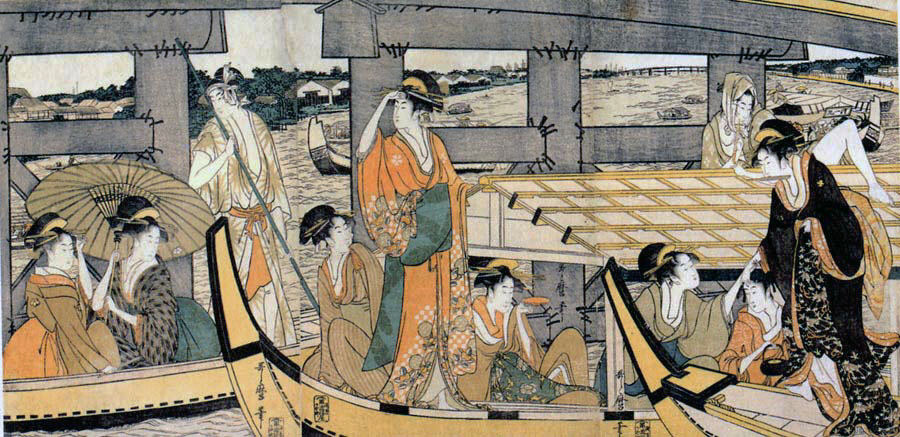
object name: print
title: Enjoying the Cool Evening Breeze on and under the Bridge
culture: japanese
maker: kitagawa utamaro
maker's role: artist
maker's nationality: japanese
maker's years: 1754-1806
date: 1800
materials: ink, paper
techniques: woodblock print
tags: bridges,women,rivers,boats